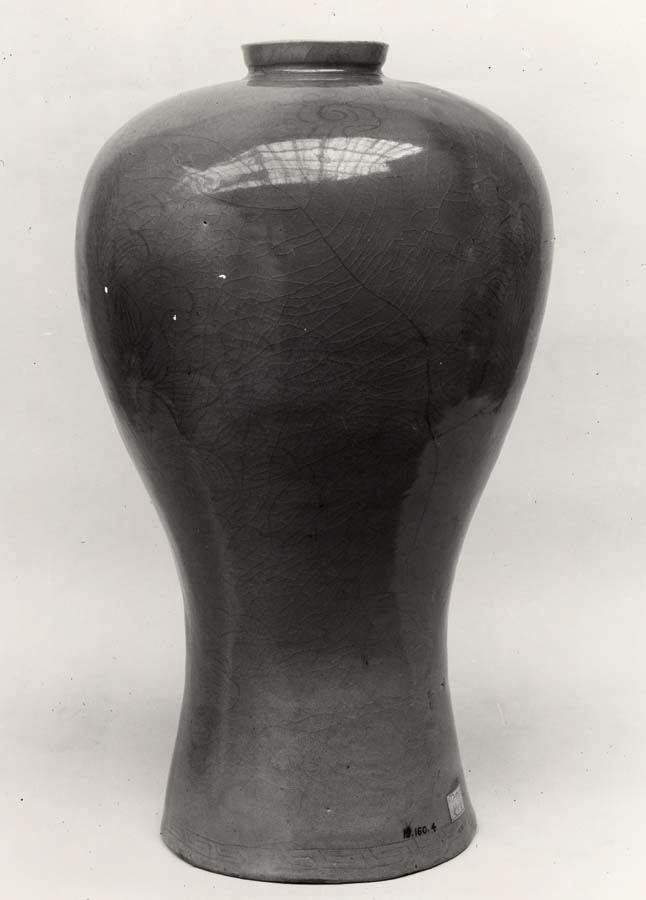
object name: jar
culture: korean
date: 1201-1300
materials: ceramic glaze, glaze, stoneware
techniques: incising